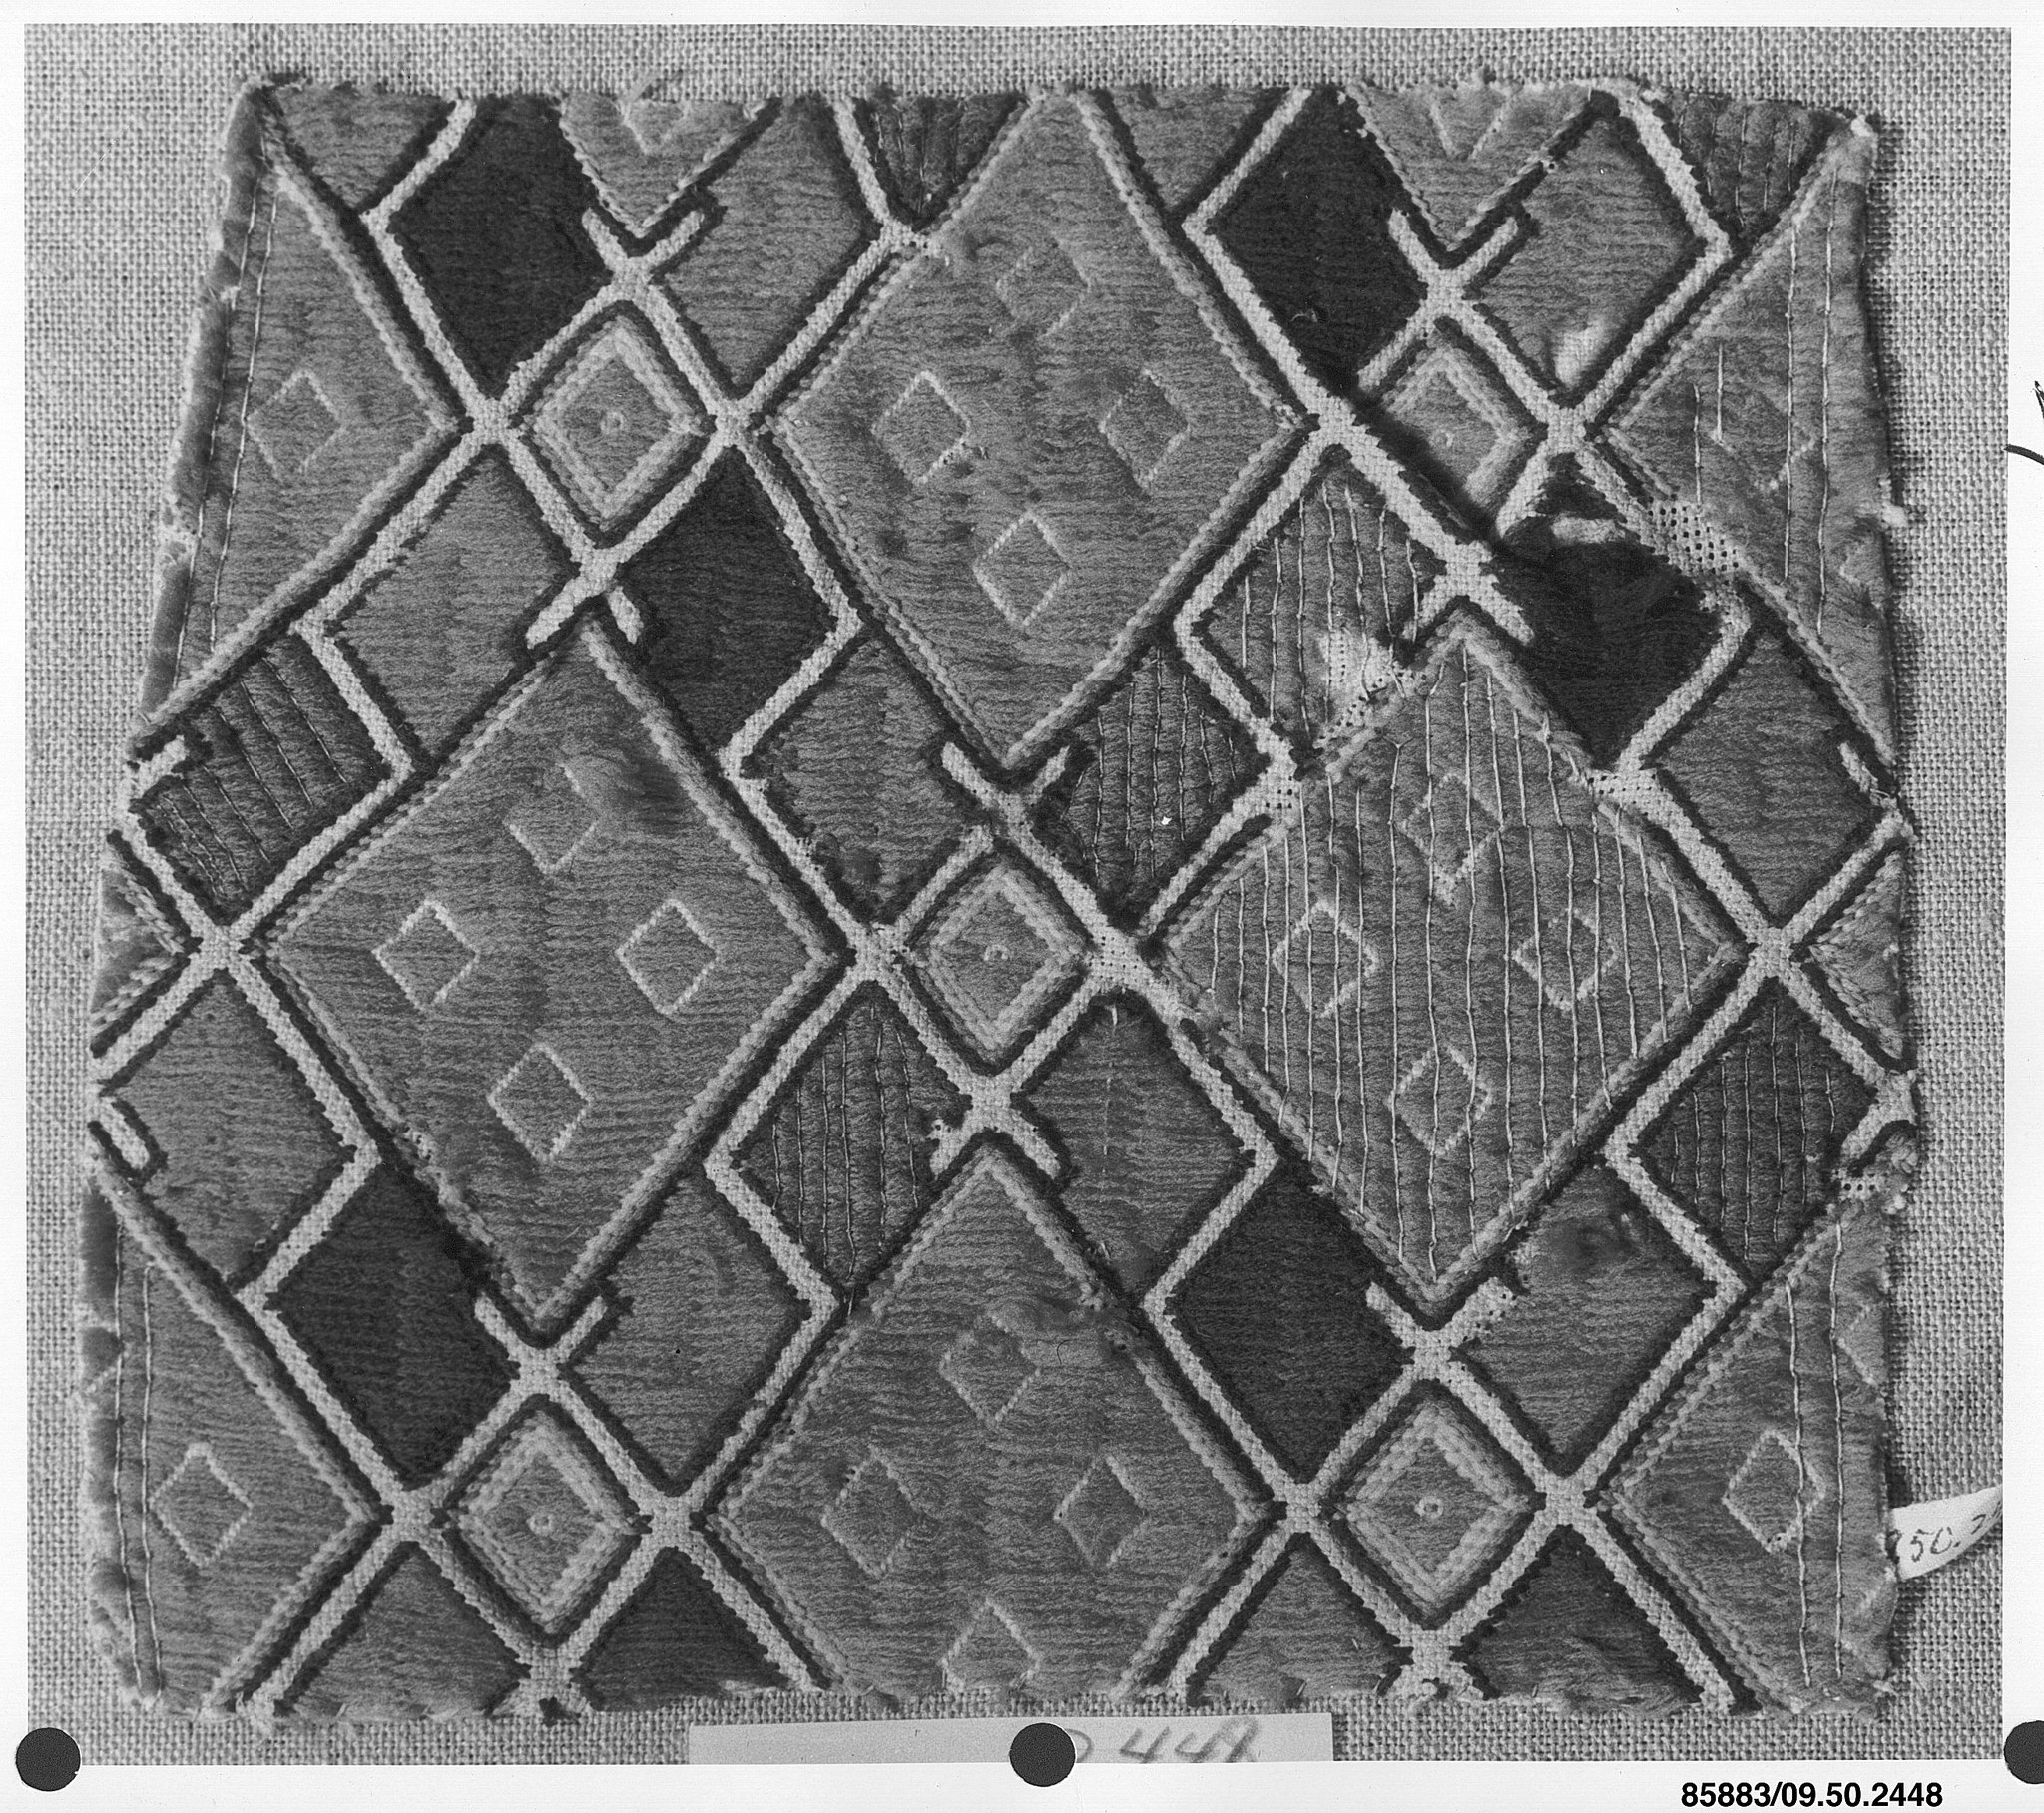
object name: fragment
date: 1701-1900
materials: canvas, wool